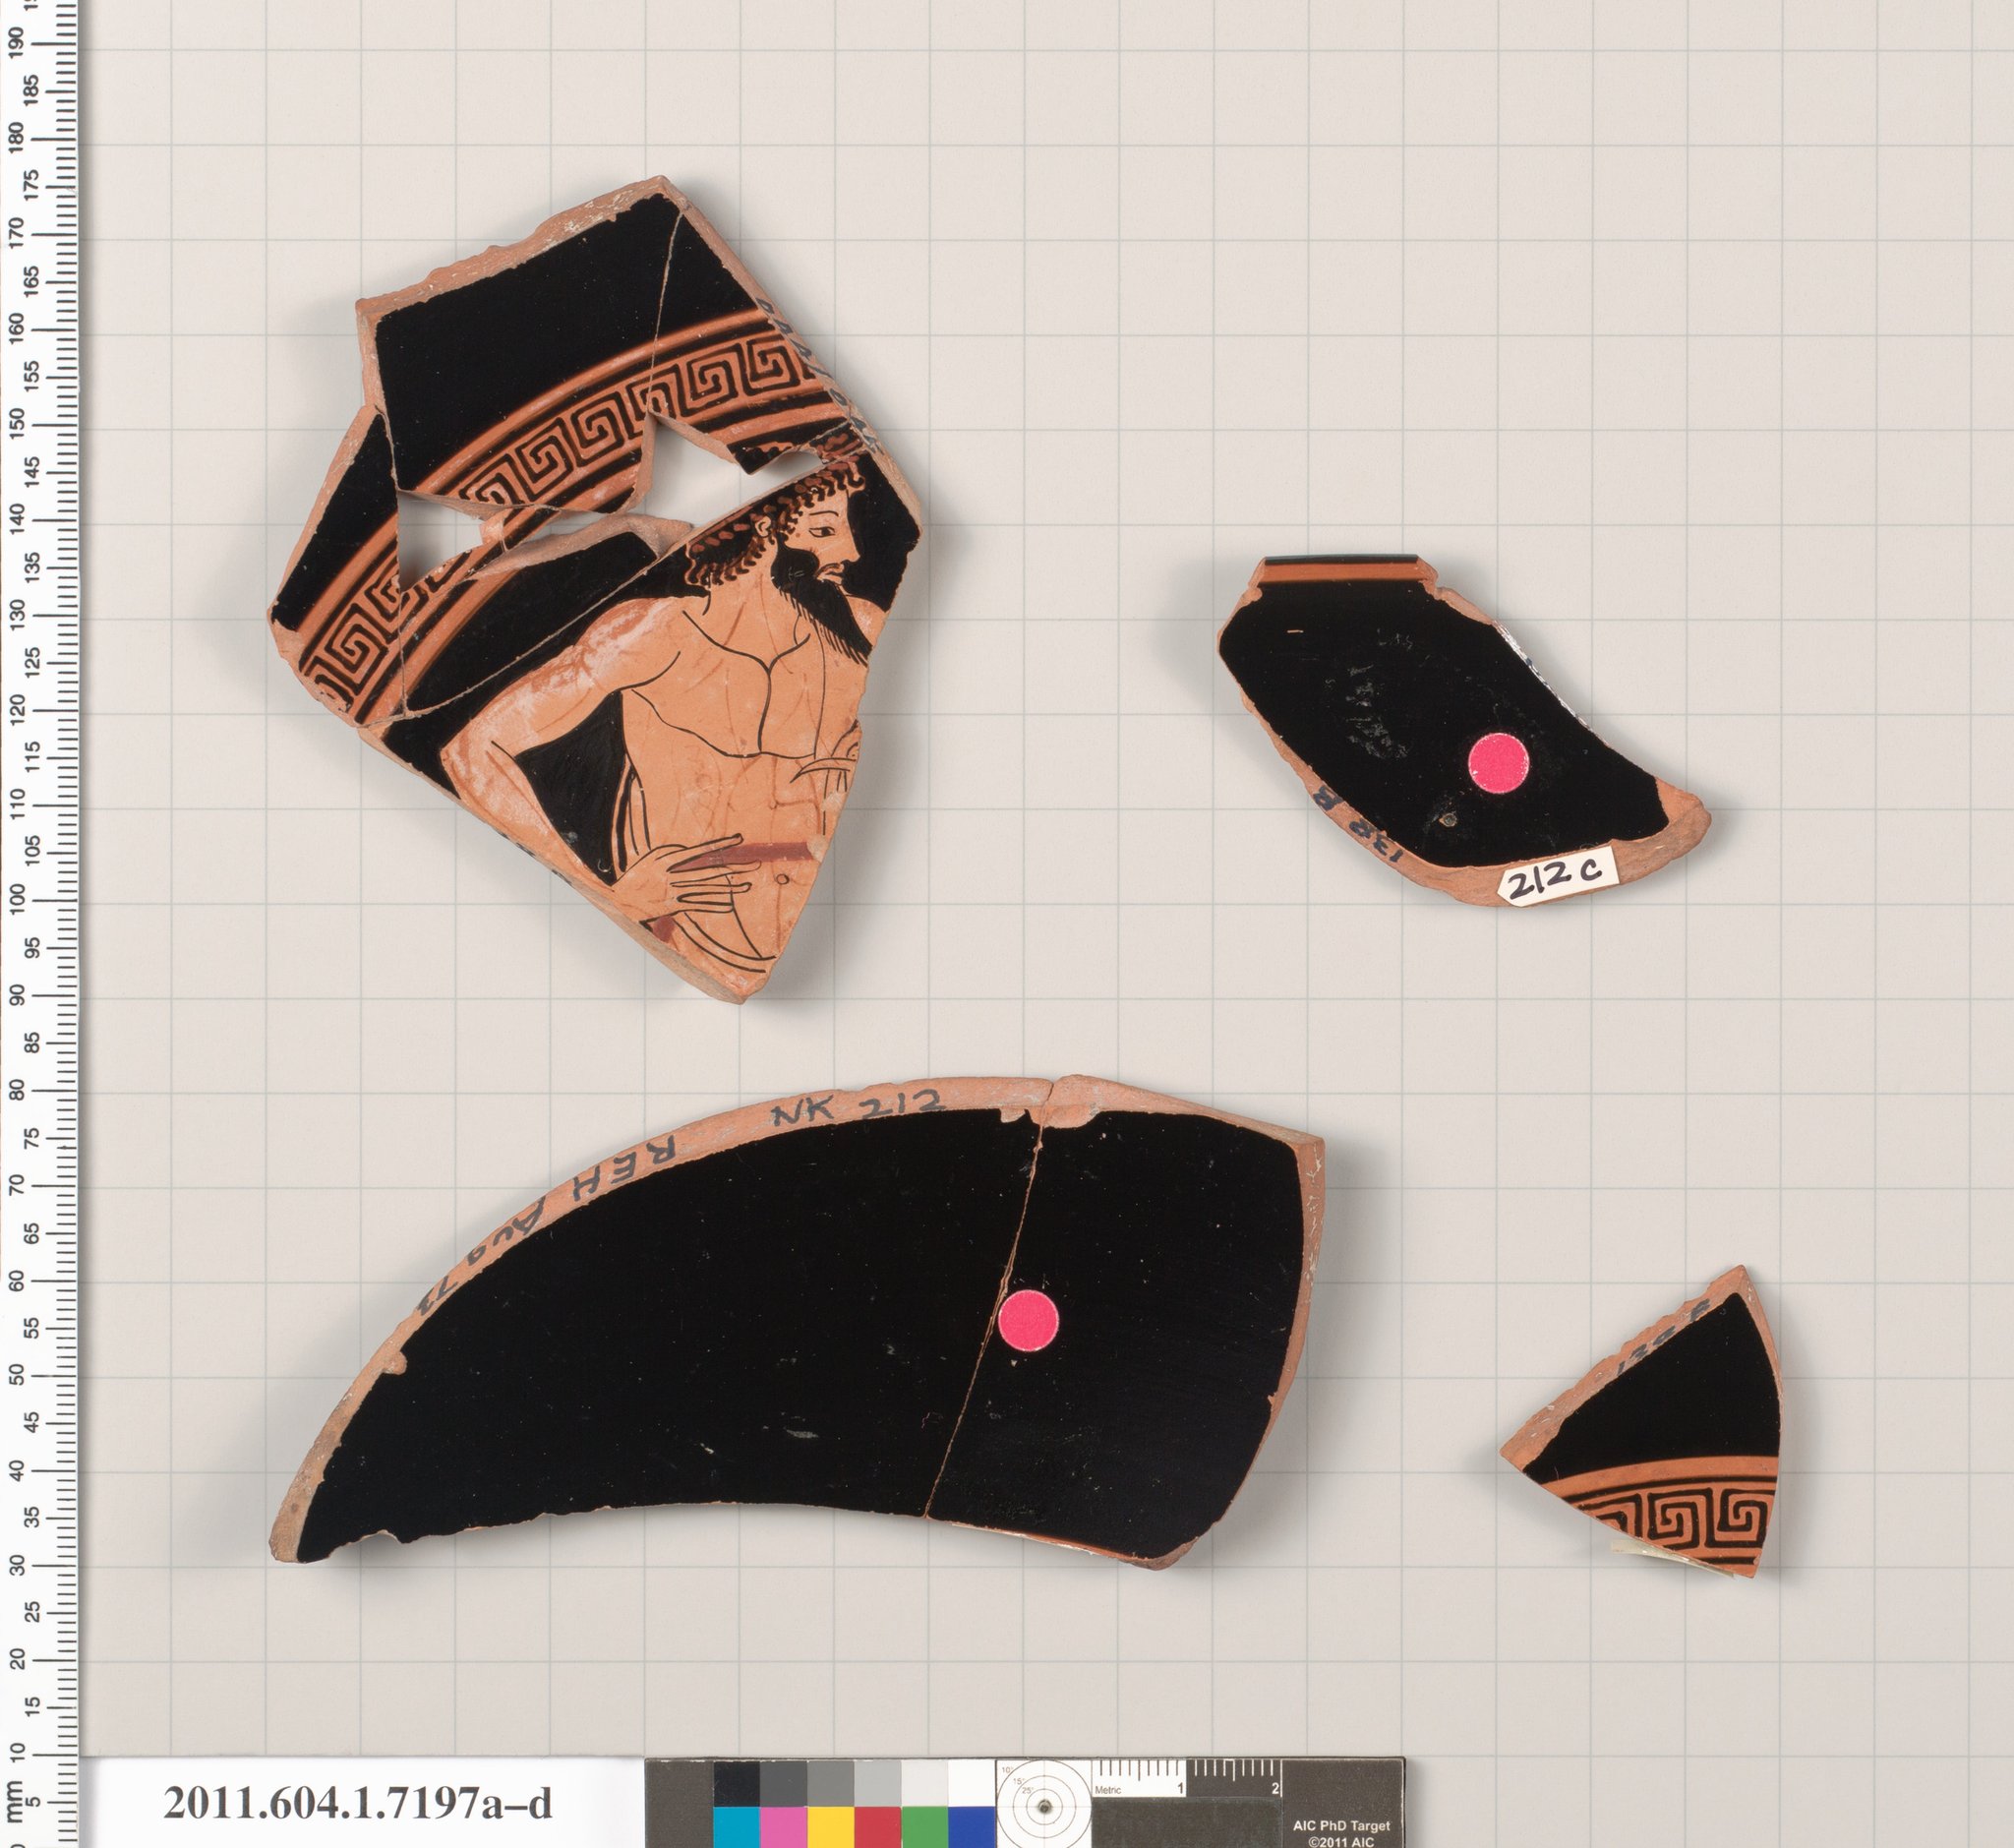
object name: kylix fragment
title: Terracotta fragments of a kylix (drinking cup)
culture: greek, attic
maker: makron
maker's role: artist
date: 500-480 BCE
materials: terracotta